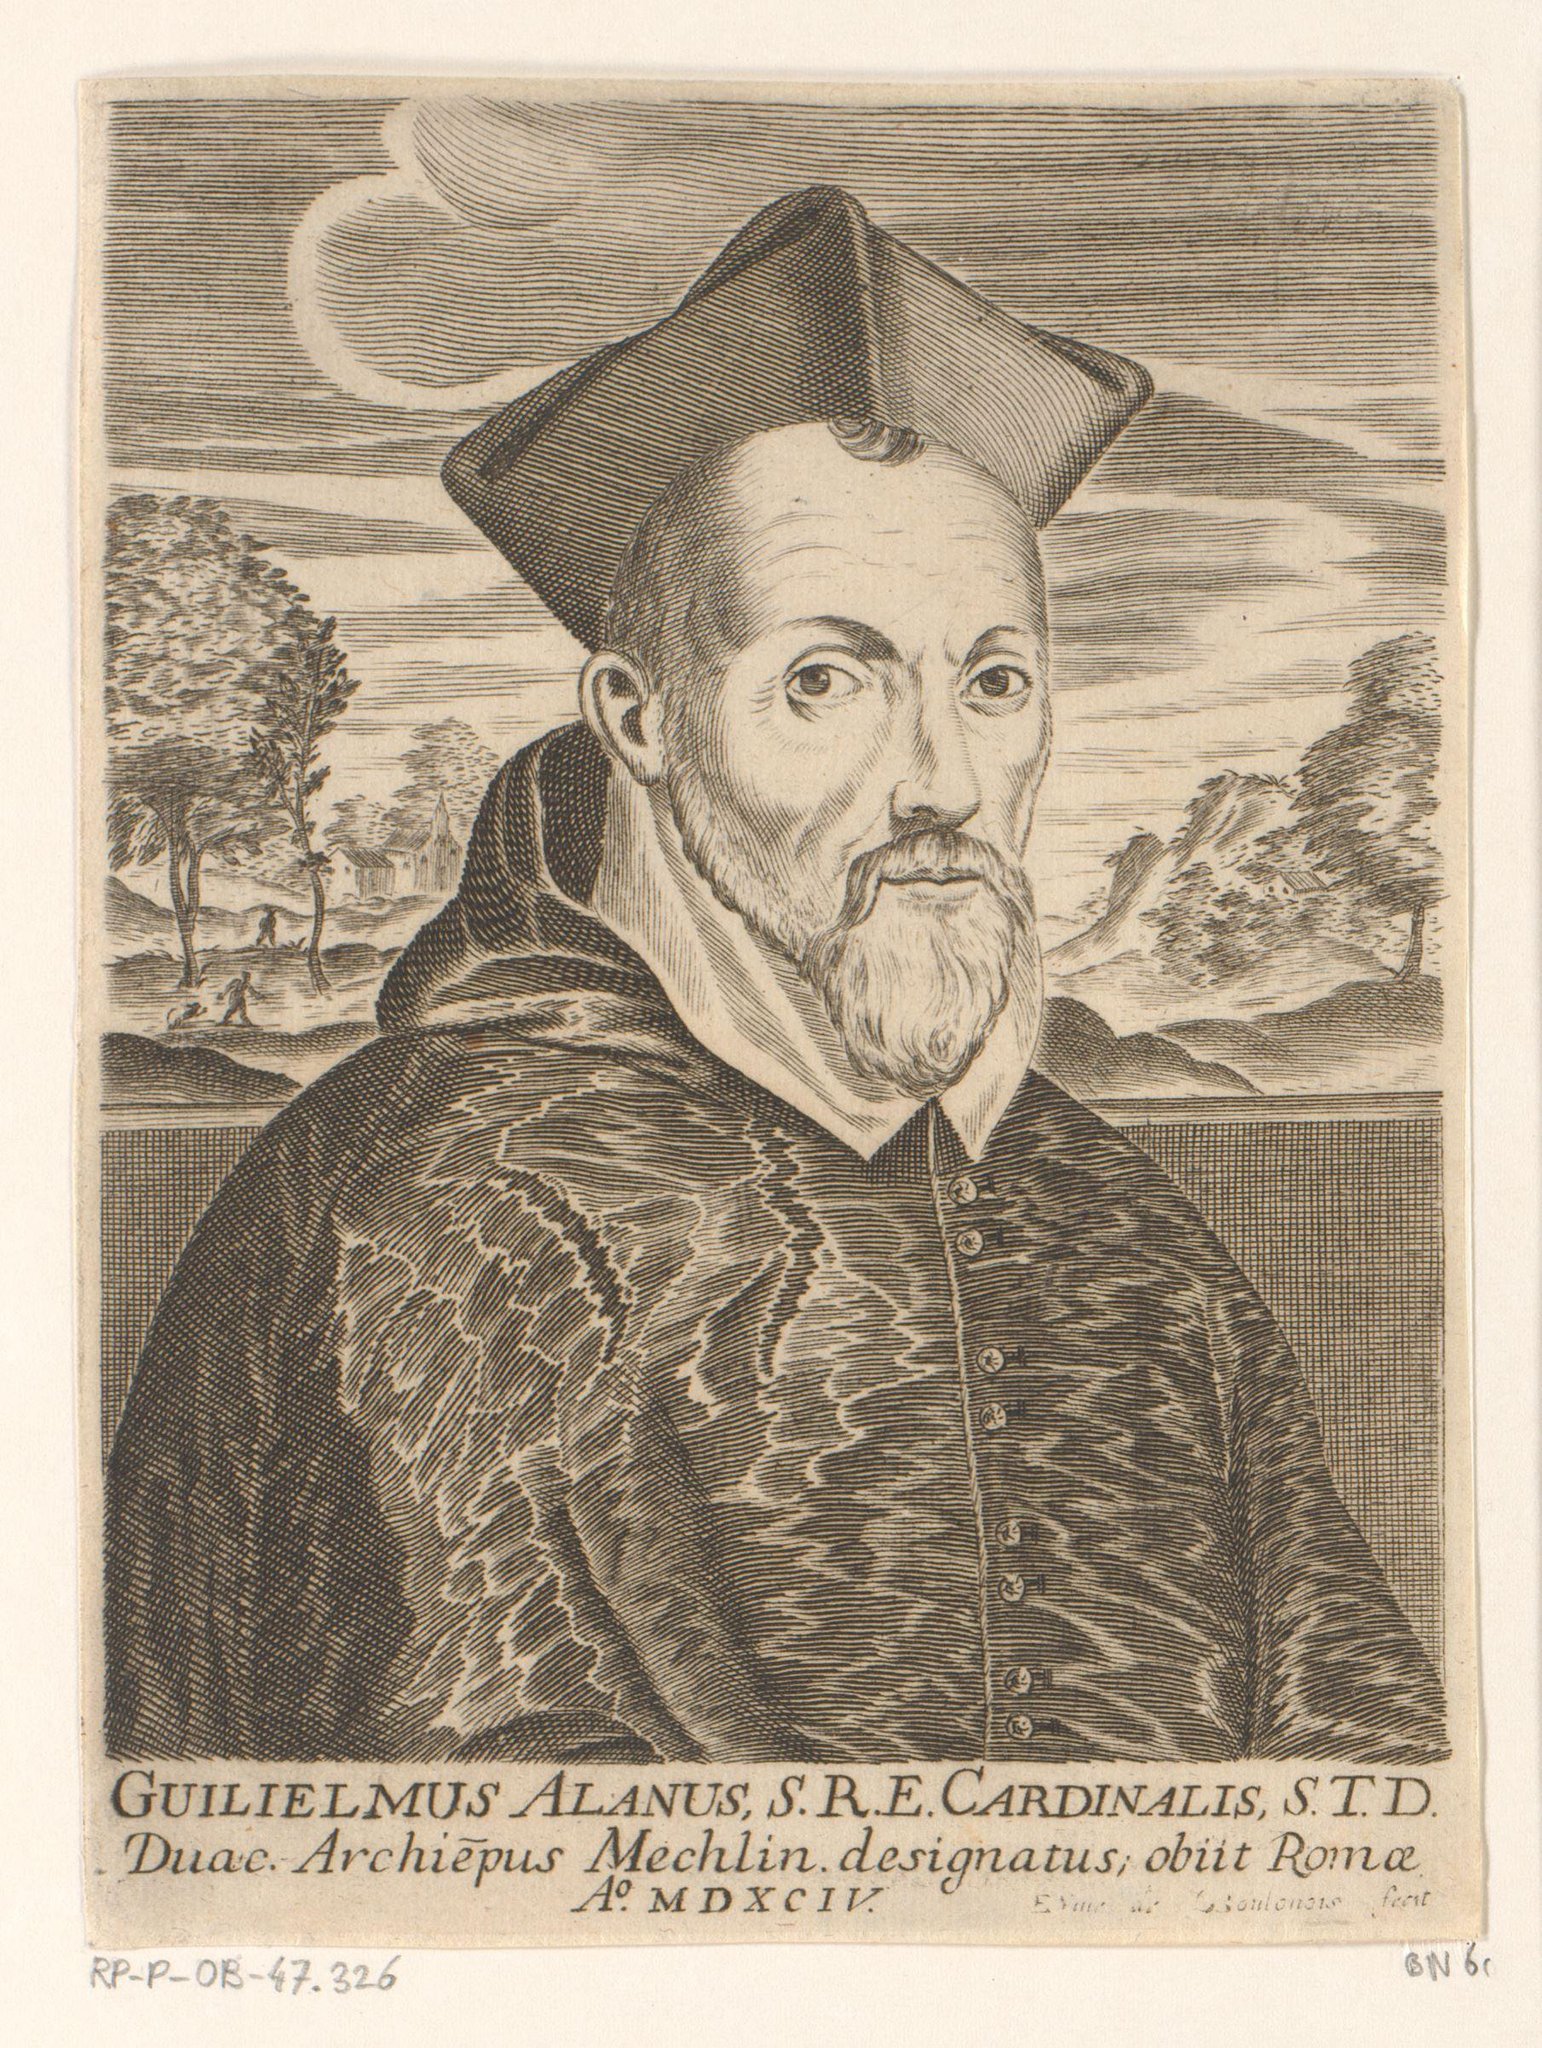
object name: print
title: Portret van kardinaal William Allen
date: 1682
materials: paper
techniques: engraving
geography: brussels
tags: rome, william allen (kardinaal), cardinal, historical persons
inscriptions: collector's mark: Lugt 2228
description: Prent uit: Bullert, Isaac. Académie des Sciences et Arts contenant les vies et éloges his. des hommes illustres qui ont excellé en ces professions depuis environ quatre siècles. Brussel: Foppens, François, 1682. Het boek werd in 1682 eveneens in Amsterdam uitgegeven door de erfgenamen van Daniel Elzevier. Deze portretten dienen ter illustratie van de biografie van een kunstenaar of geleerde. De meeste portretten werden door Nicolas de Larmessin vervaardigd (162), 93 door De Boulonois en een derde door ongeïdentificeerde prentmakers. Dit betreft de illustratie op p. 37, deel II.